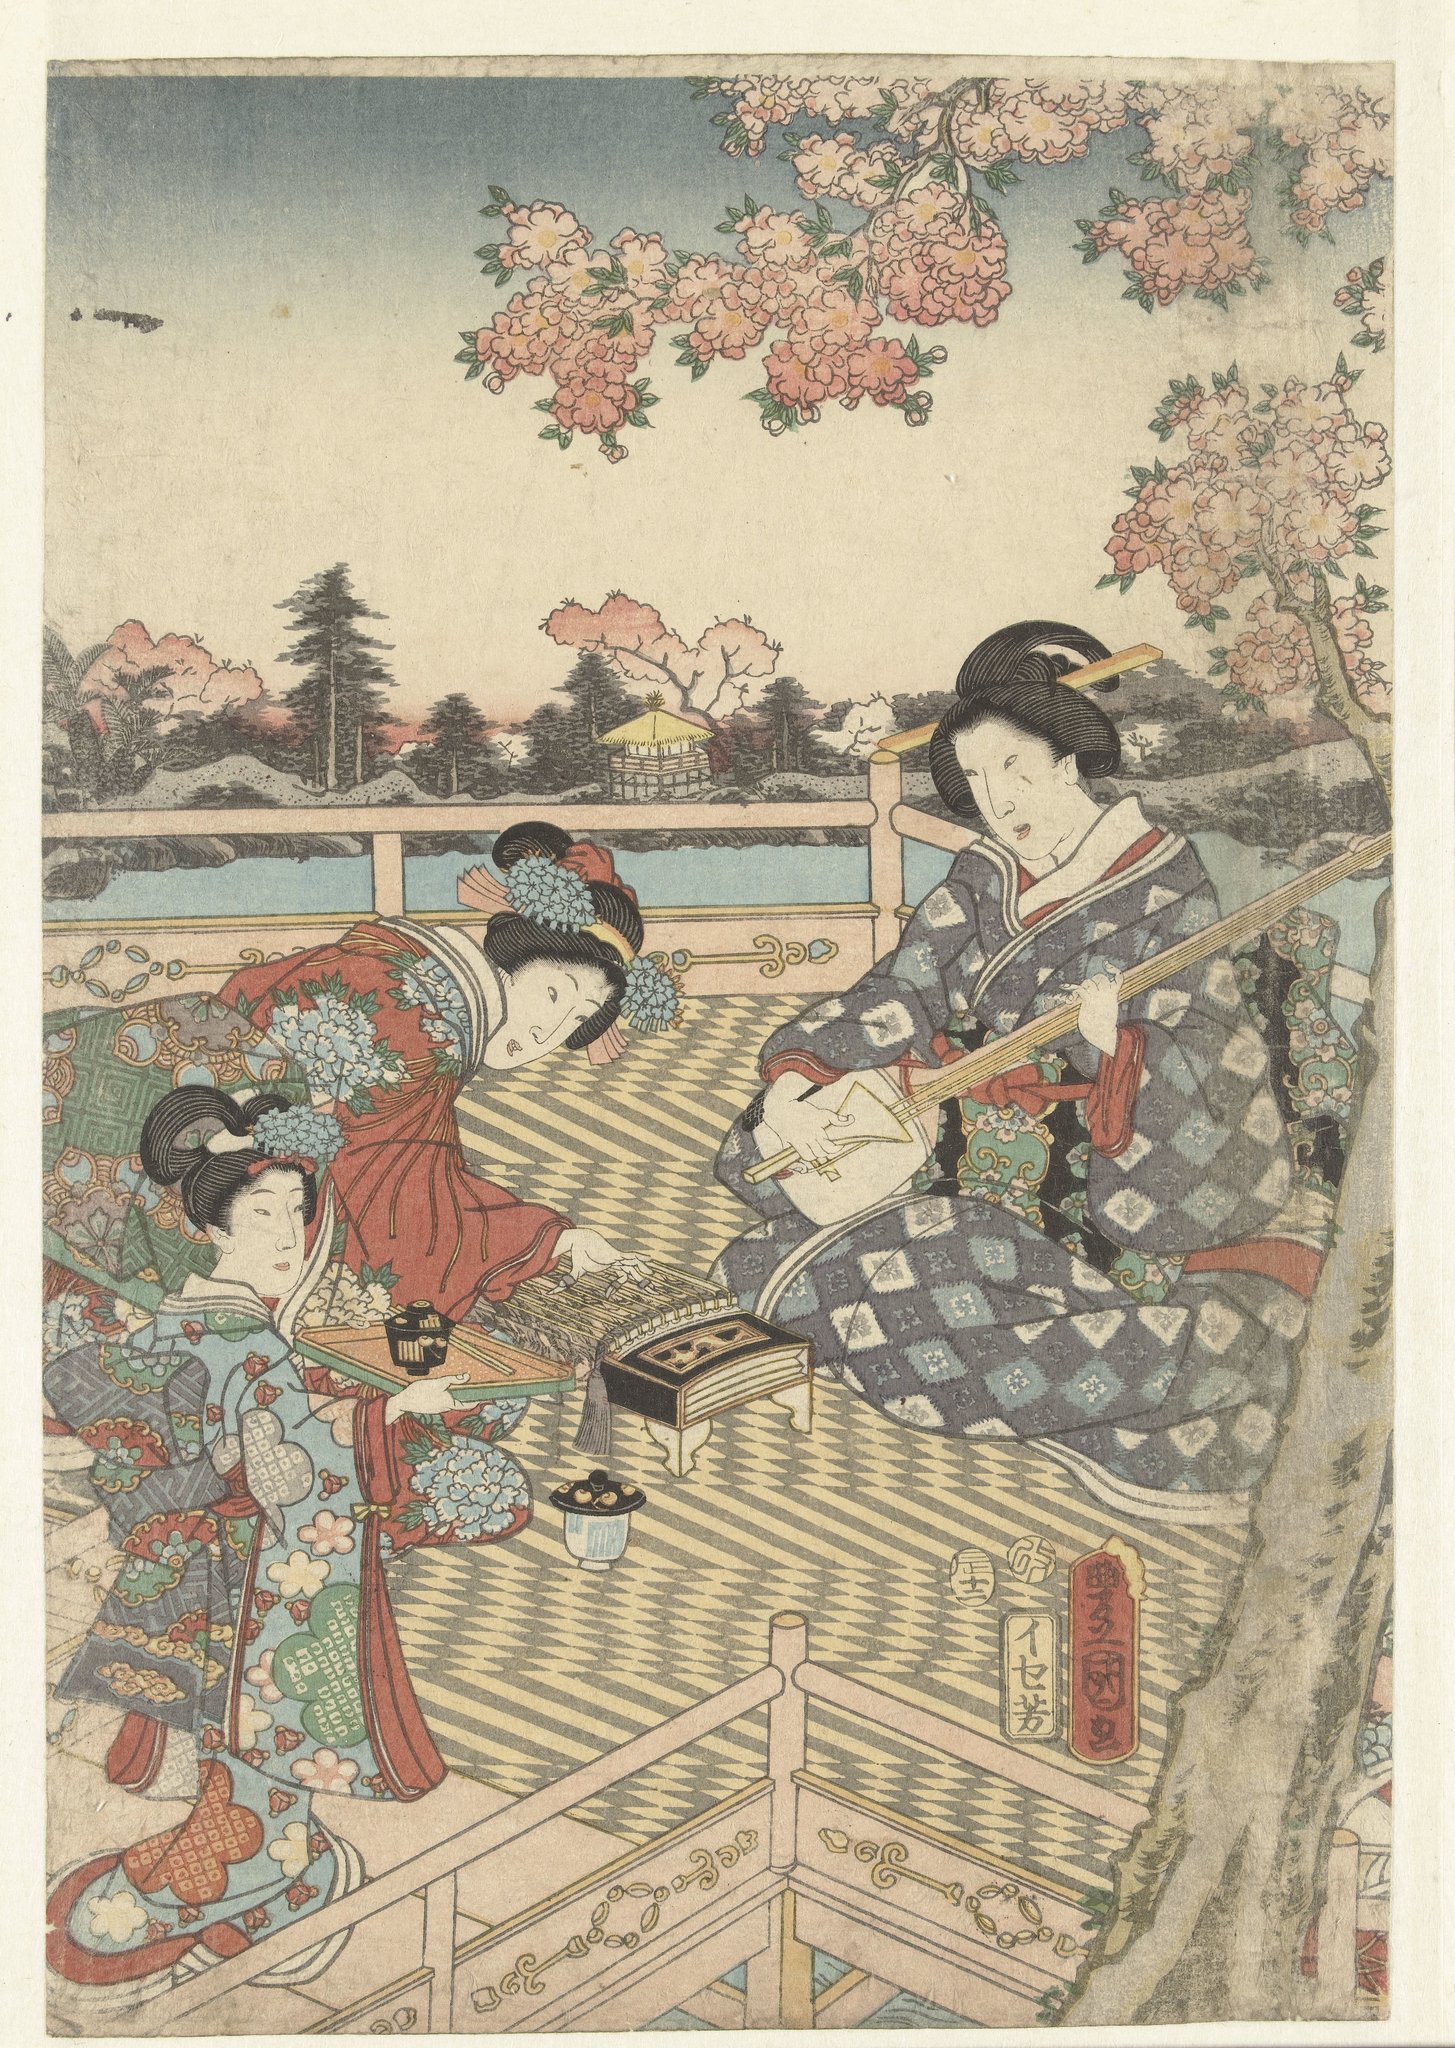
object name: print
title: Azuma Genji hana no yuen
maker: utagawa kunisada (i)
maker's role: print maker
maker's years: 1786-1865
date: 1856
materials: paper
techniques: woodcut, nishiki e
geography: japan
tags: musical instruments; group of musical instruments, adult woman (+ two persons), toddler - aa - girl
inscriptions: date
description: Meisje met dienblad en twee musicerende vrouwen, één met koto, de ander met shamisen, op terras over vijver; op de voorgrond een bloesemende boom.